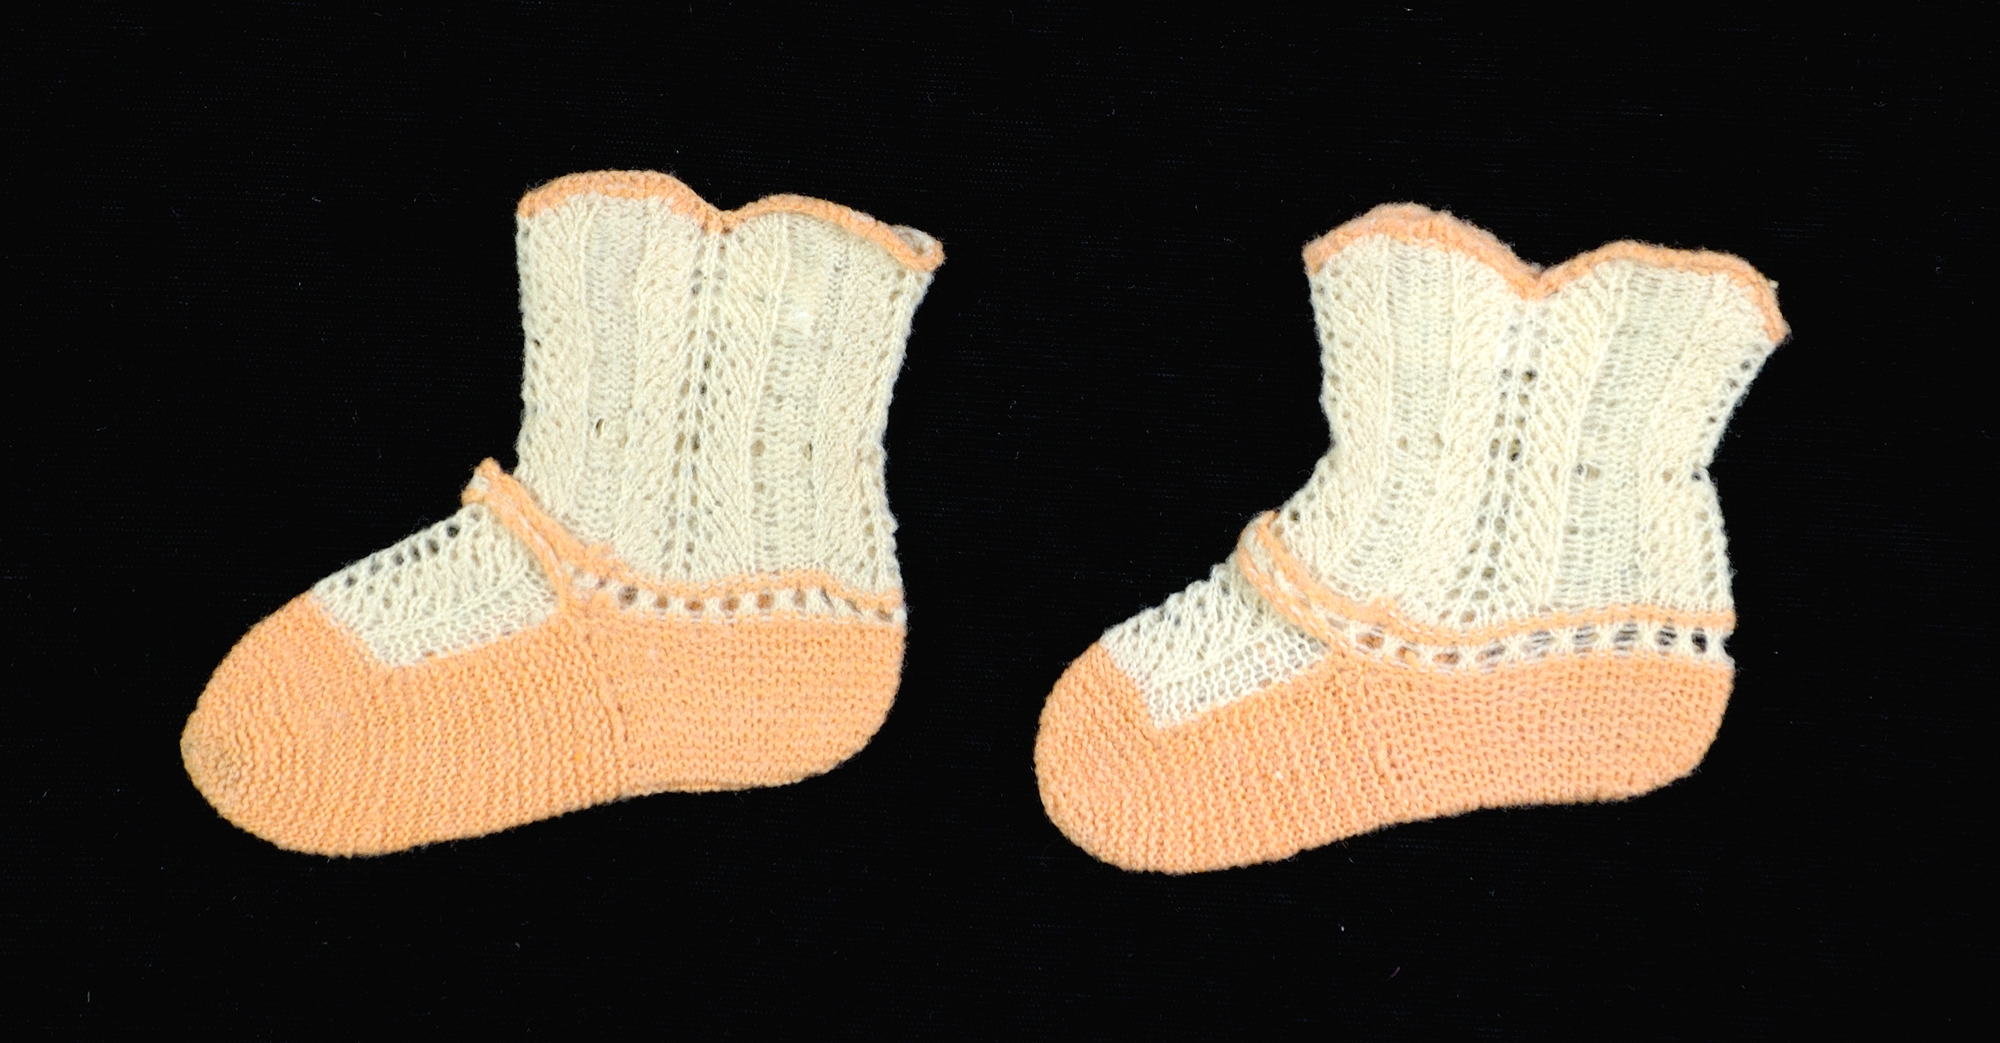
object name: bootee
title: Bootees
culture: american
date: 1840-1860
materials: wool